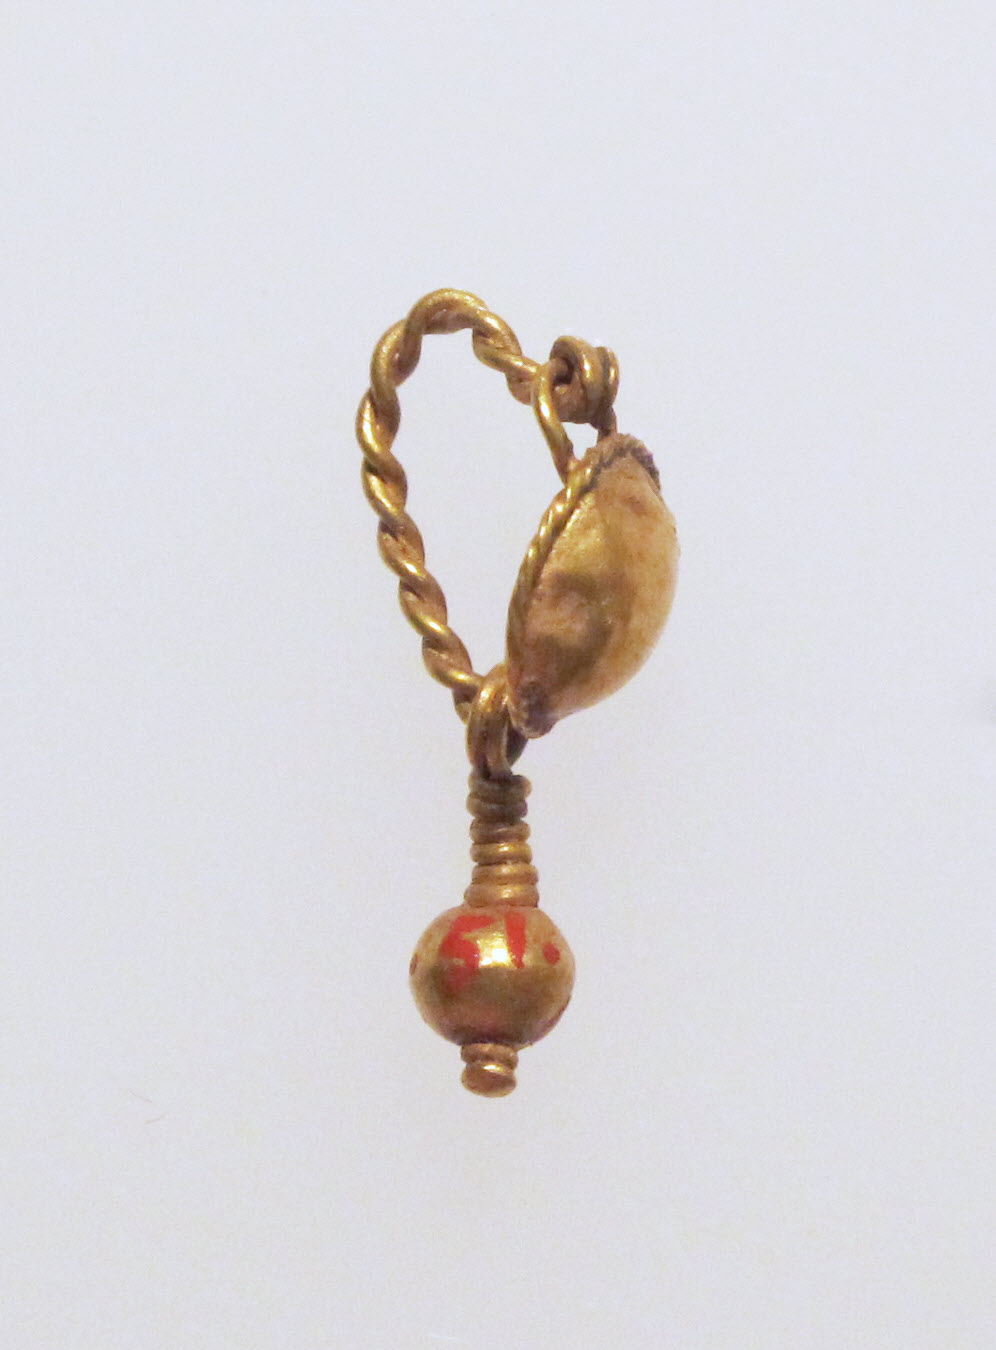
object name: earring with pendant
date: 7000 BCE-330 CE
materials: gold